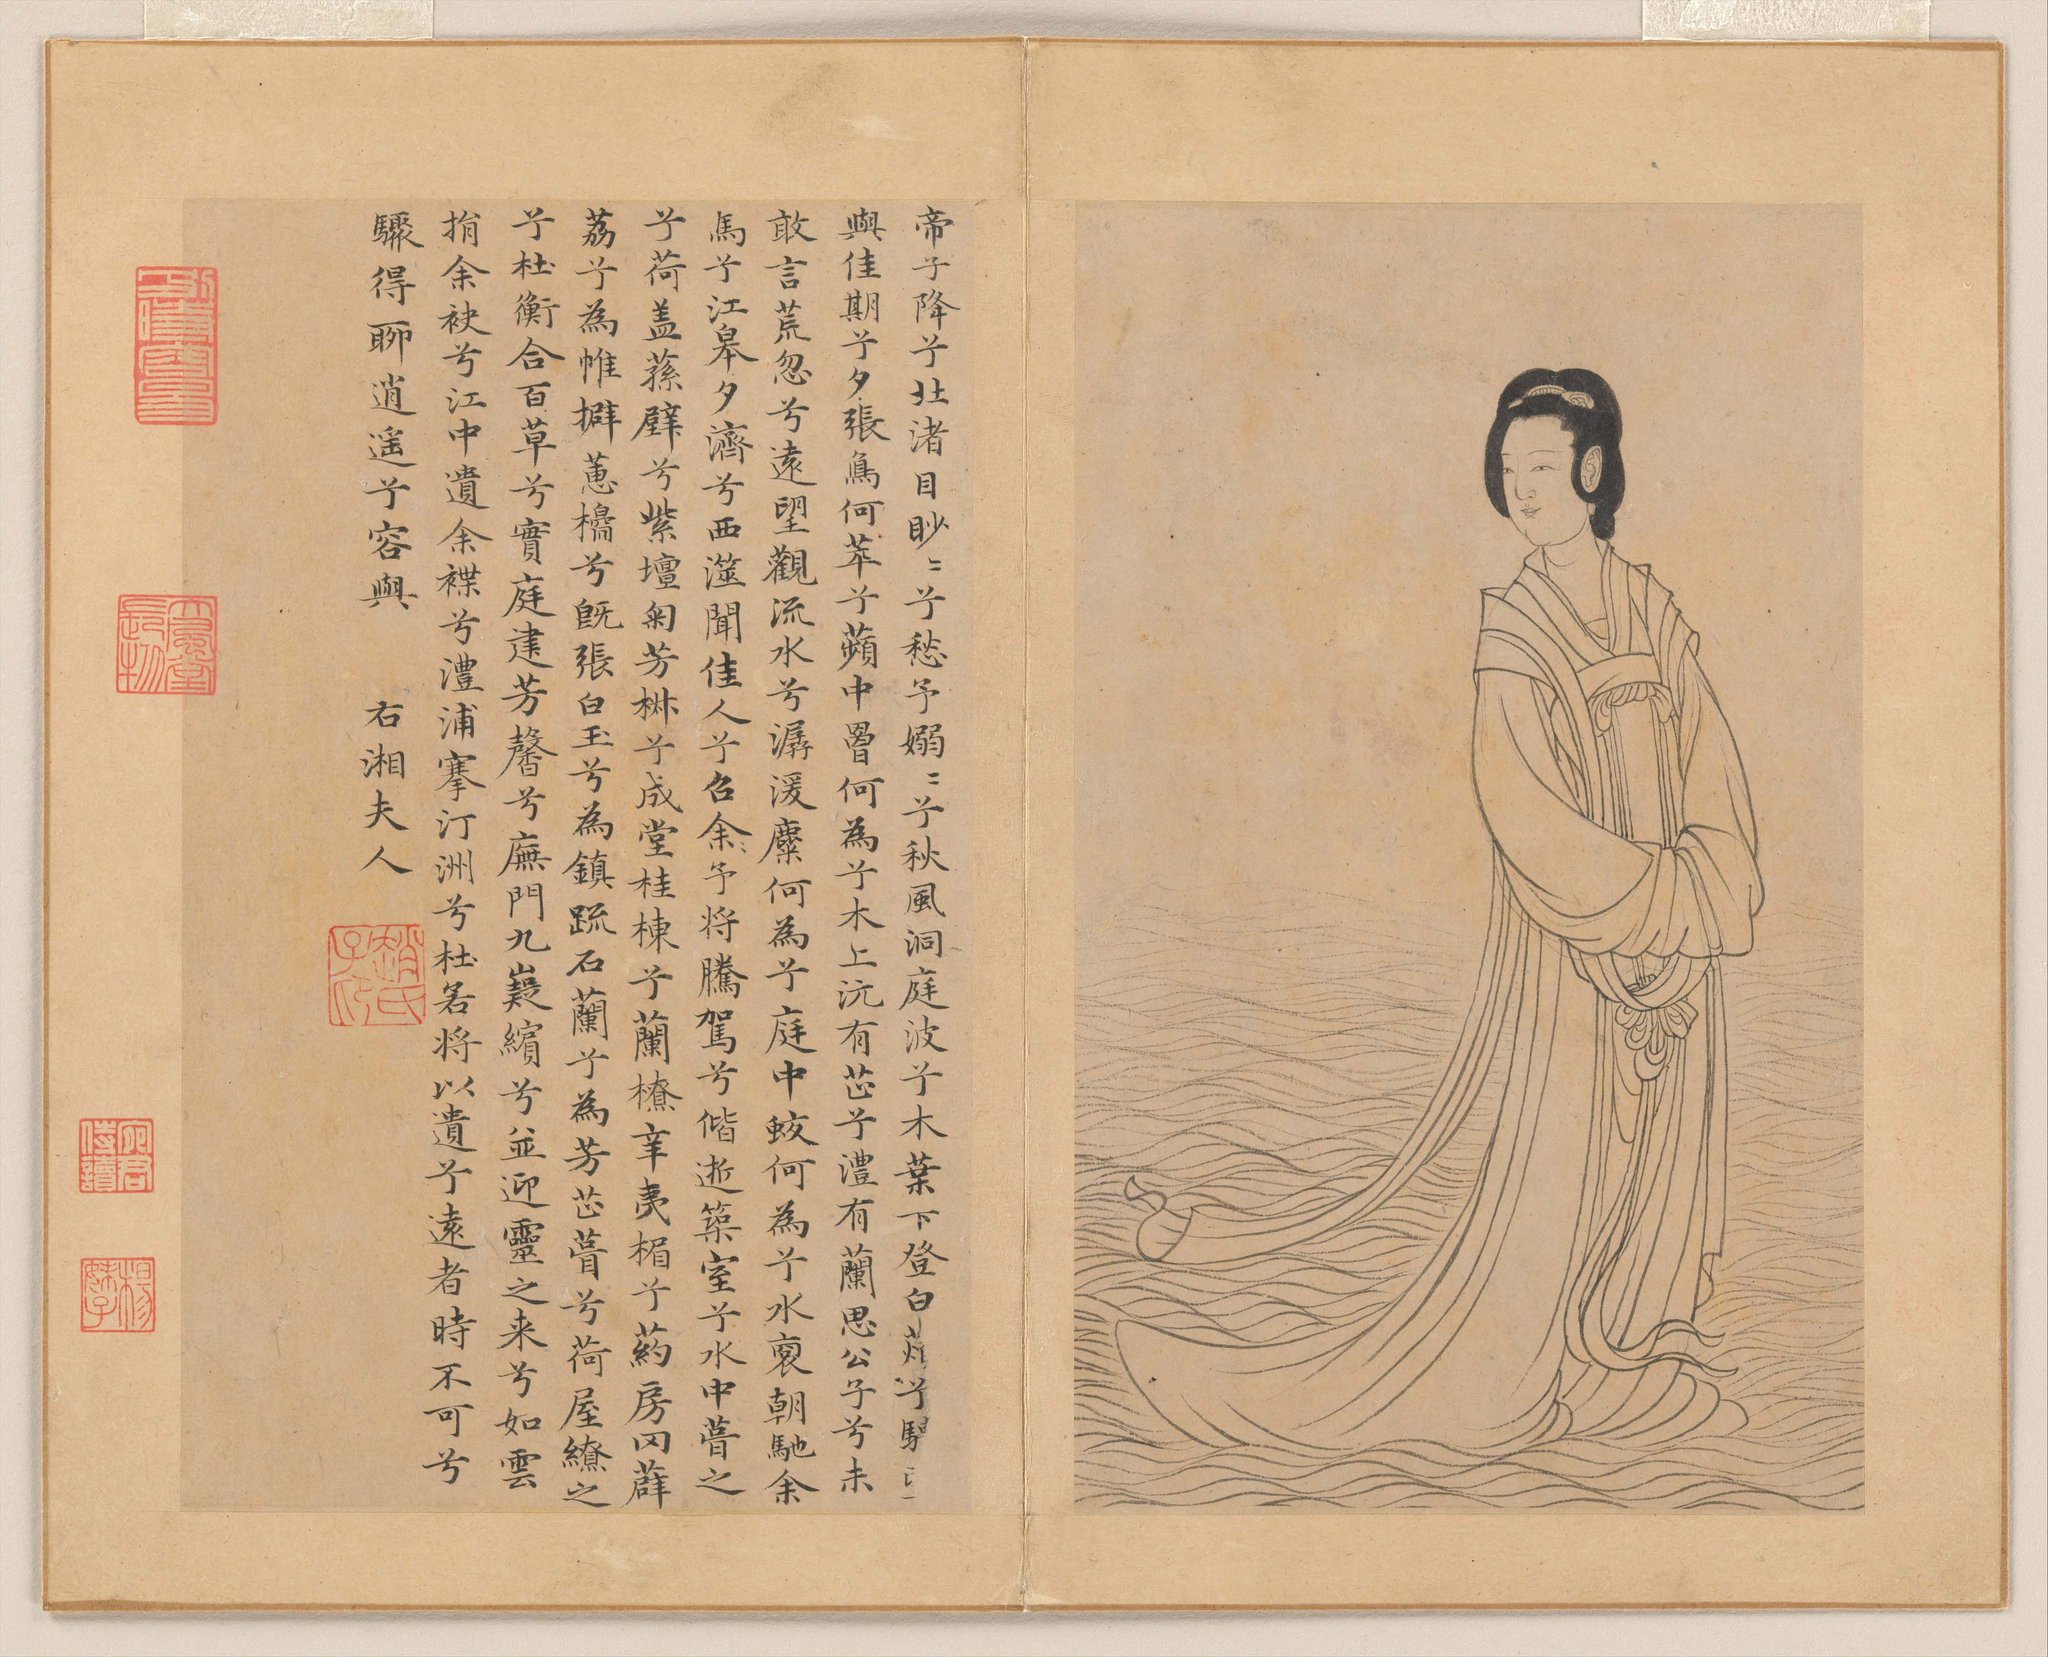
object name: album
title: Nine Songs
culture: chinese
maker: zhao mengfu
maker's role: artist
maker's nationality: chinese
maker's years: 1254-1322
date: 1301-1500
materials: ink, paper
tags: men,women